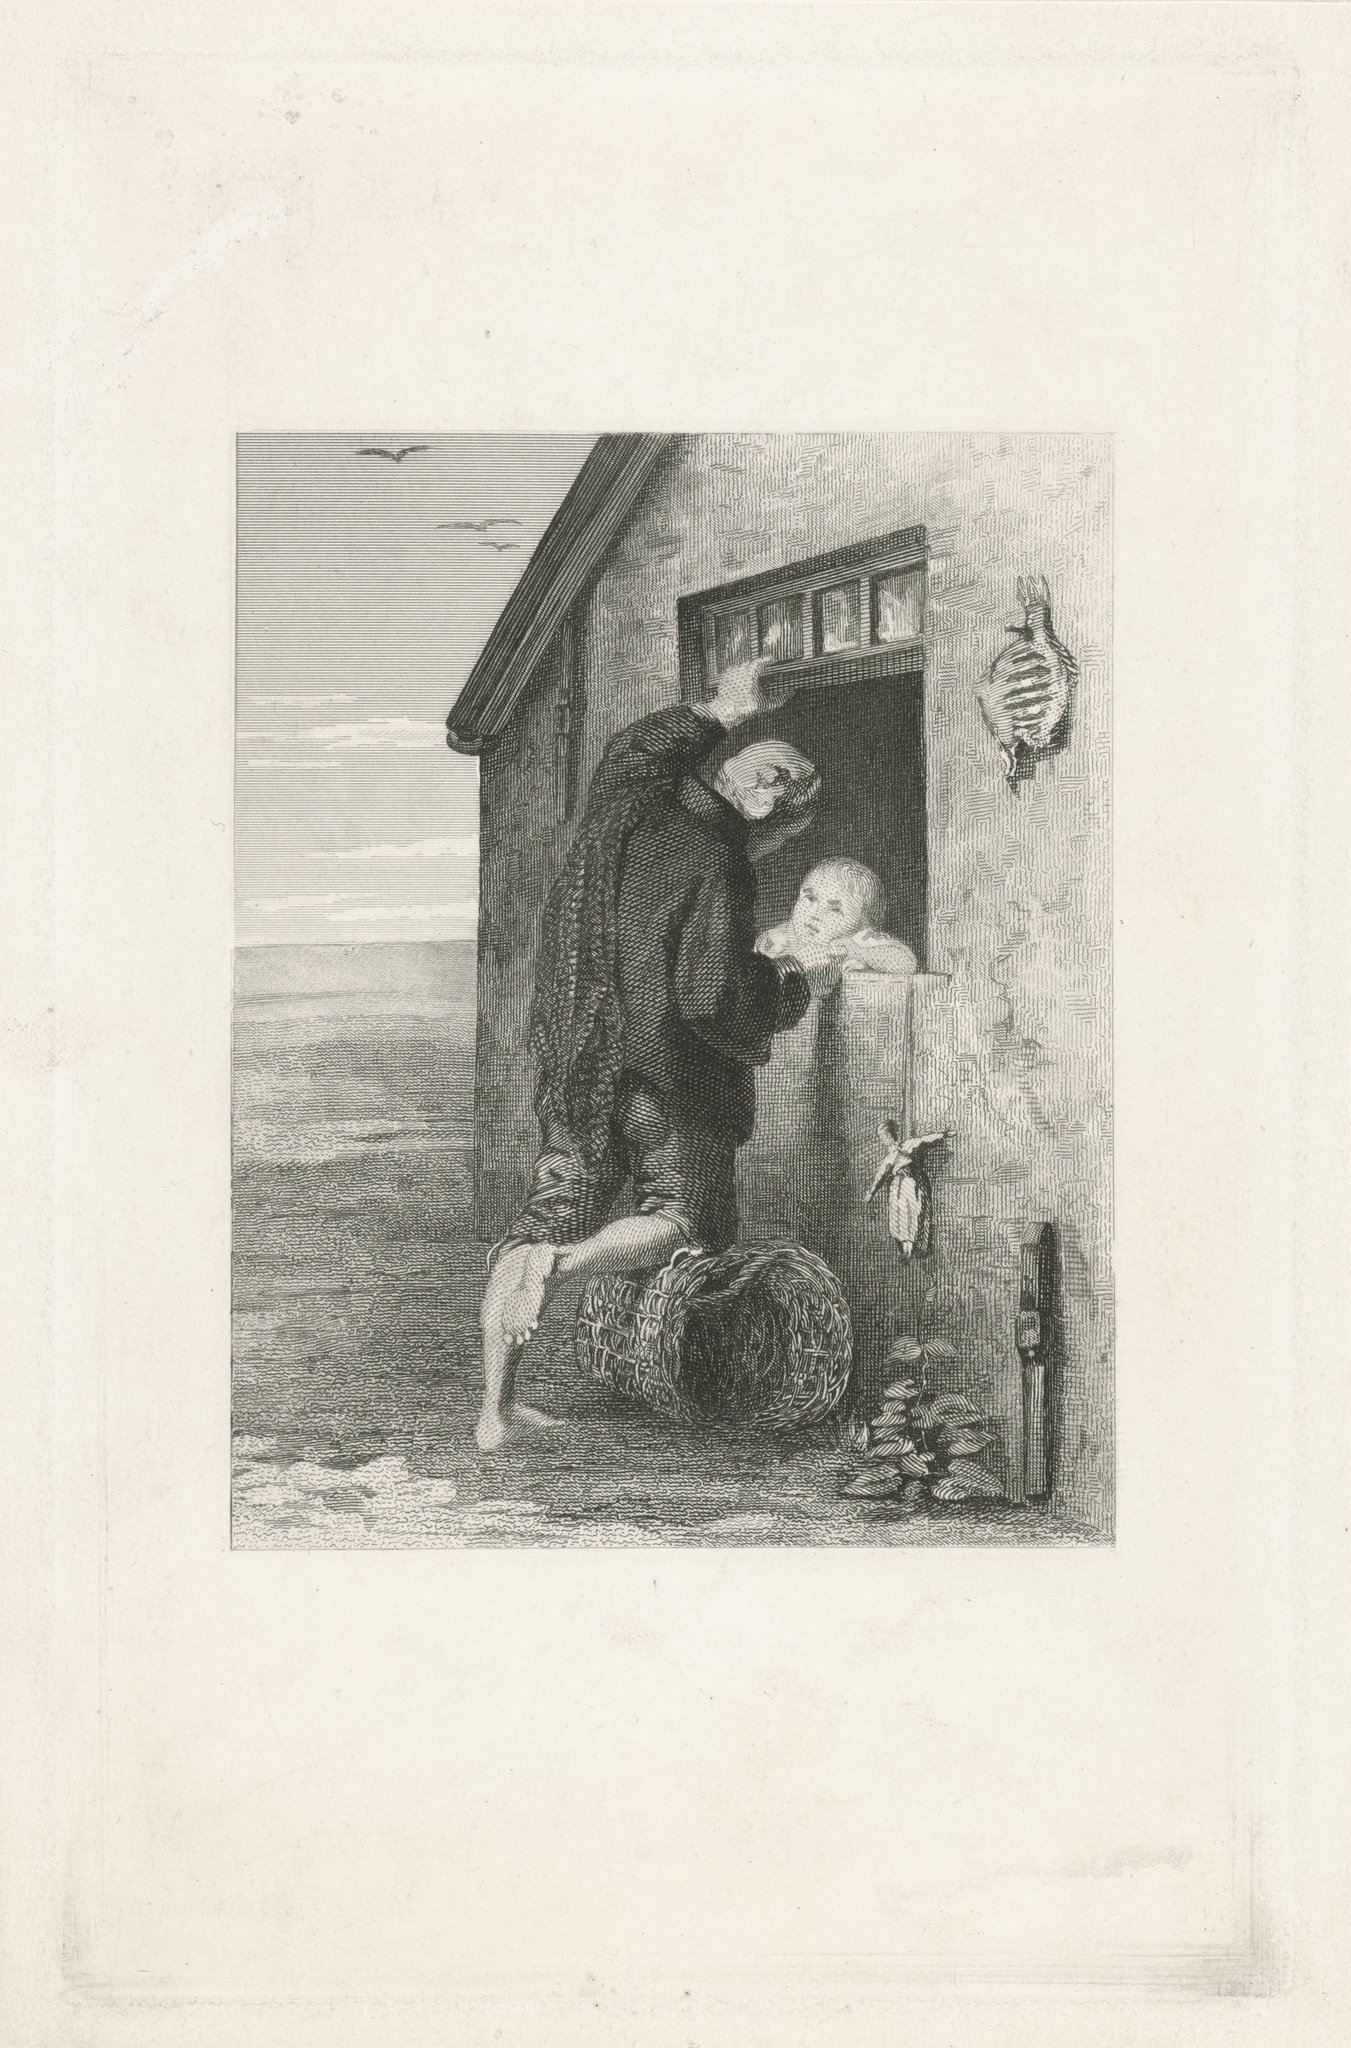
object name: print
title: Gesprek tussen een visser en een kind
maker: johann heinrich maria hubert rennefeld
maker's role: print maker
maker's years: 1832-1877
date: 1855-1877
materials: paper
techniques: roulette, engraving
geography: amsterdam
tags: (playing with) dolls, conversation, dialogue; conversation piece, beach, fisherman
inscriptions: collector's mark: Lugt 2228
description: Een visser staat voor het raam van een huis te praten met een klein kind. Hij leunt met zijn knie op een rieten mand en het kind laat een pop aan een touw door het venster naar buiten bungelen. Op de achtergrond het strand en de zee.